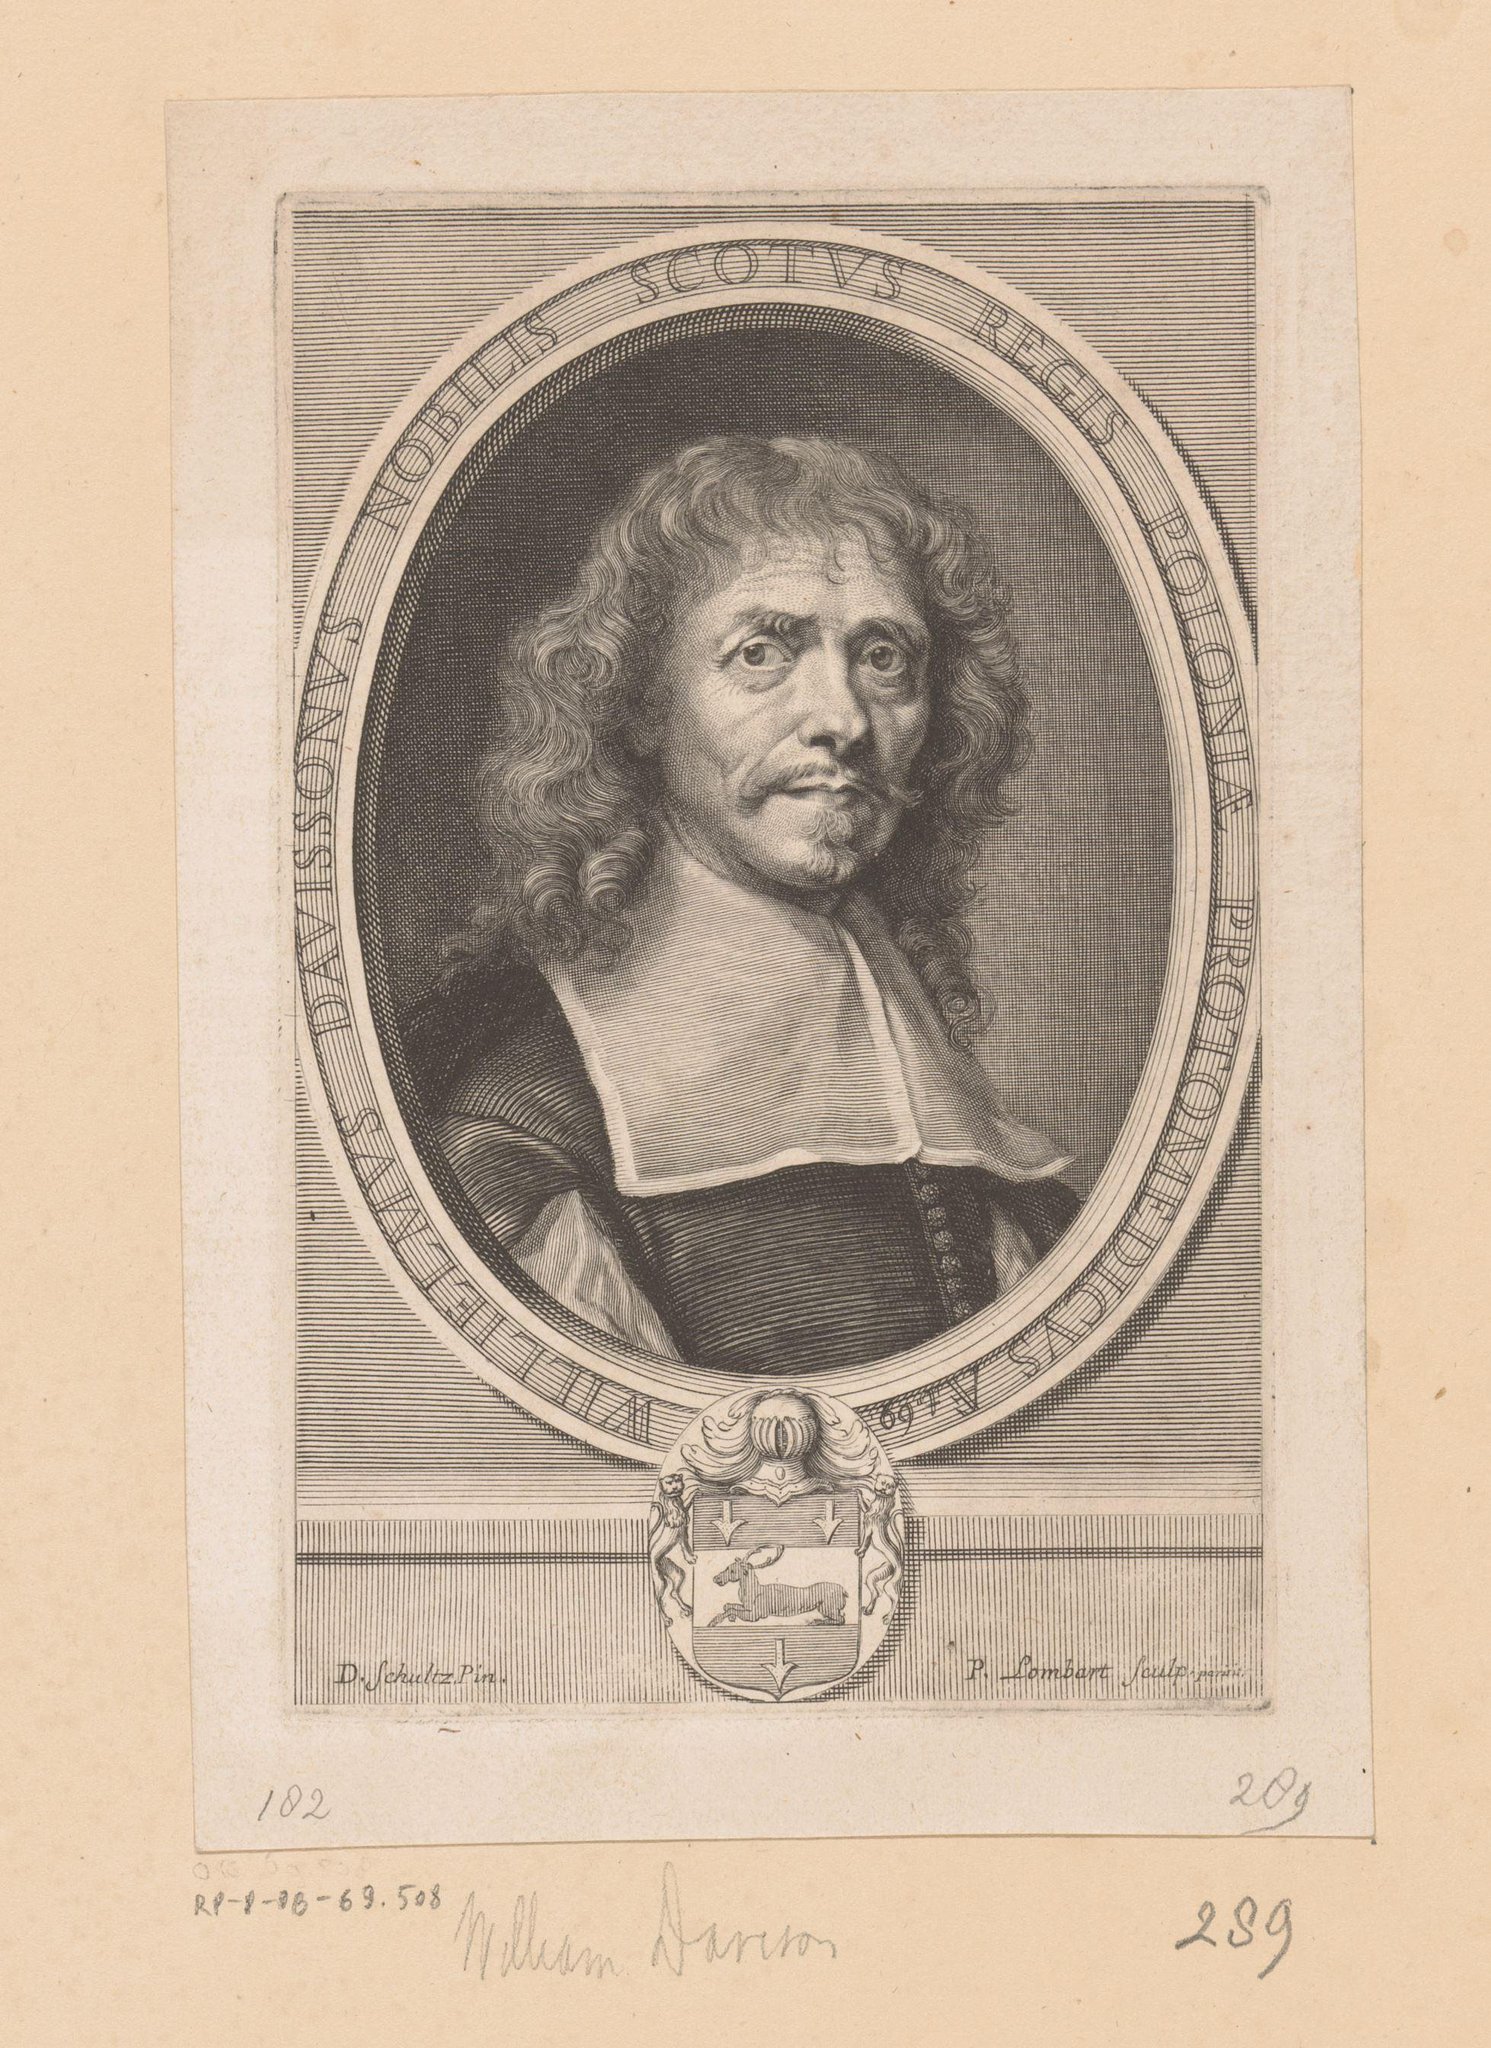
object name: print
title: Portret van William Davison op 69-jarige leeftijd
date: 1660-1680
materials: paper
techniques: engraving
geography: paris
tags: secretary of state, state secretary ~ government, historical persons, armorial bearing, heraldry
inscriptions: collector's mark: Lugt 240